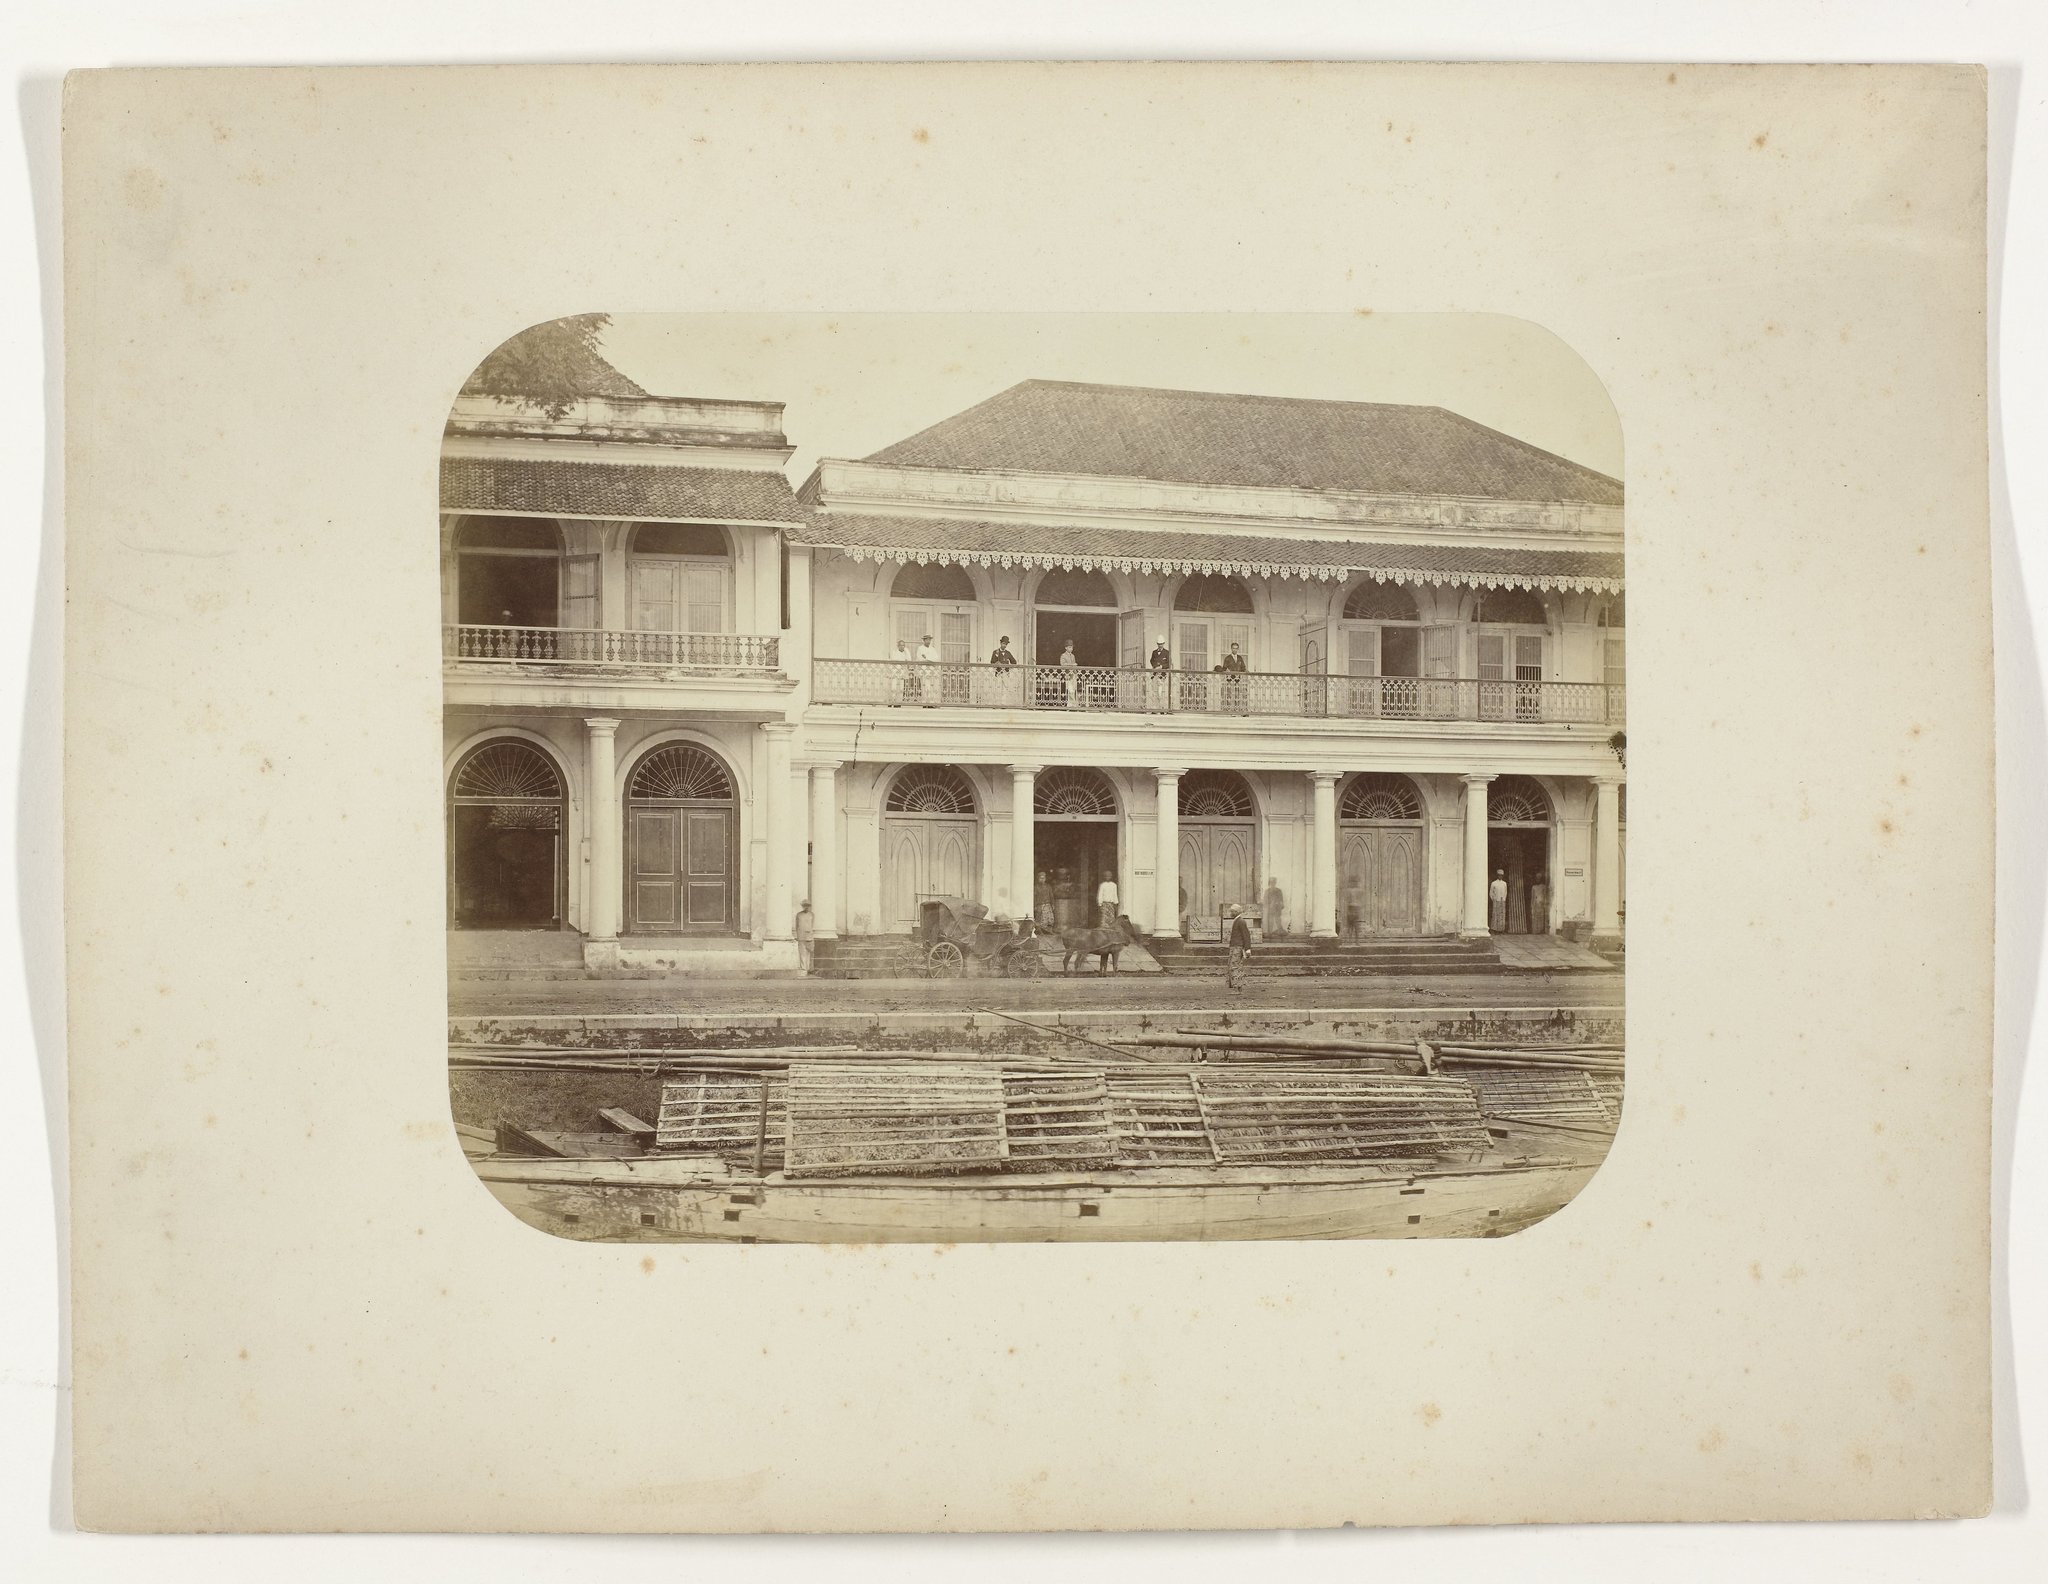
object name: photograph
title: Het handelsbureau aan de Kali Mas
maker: herman salzwedel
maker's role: fotograaf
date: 1876-1884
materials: photographic support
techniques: albumen print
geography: batavia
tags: the hague, colonial system, locations for trading, surabaya, java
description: Het handelsbureau aan de Kali Mas in Soerabaja met op de brede galerij een zestal Europeanen. Voor het gebouw een paard en wagen en op de voorgrond een prauw aan de kade. Op het bordje naast de linkeringang Burt Myrtle & Co. Onderdeel van het fotoalbum door de Soerabayasche Vereeniging van Suikerfabrikanten aangeboden aan Frederik Beyerinck, resident van Soerabaja.